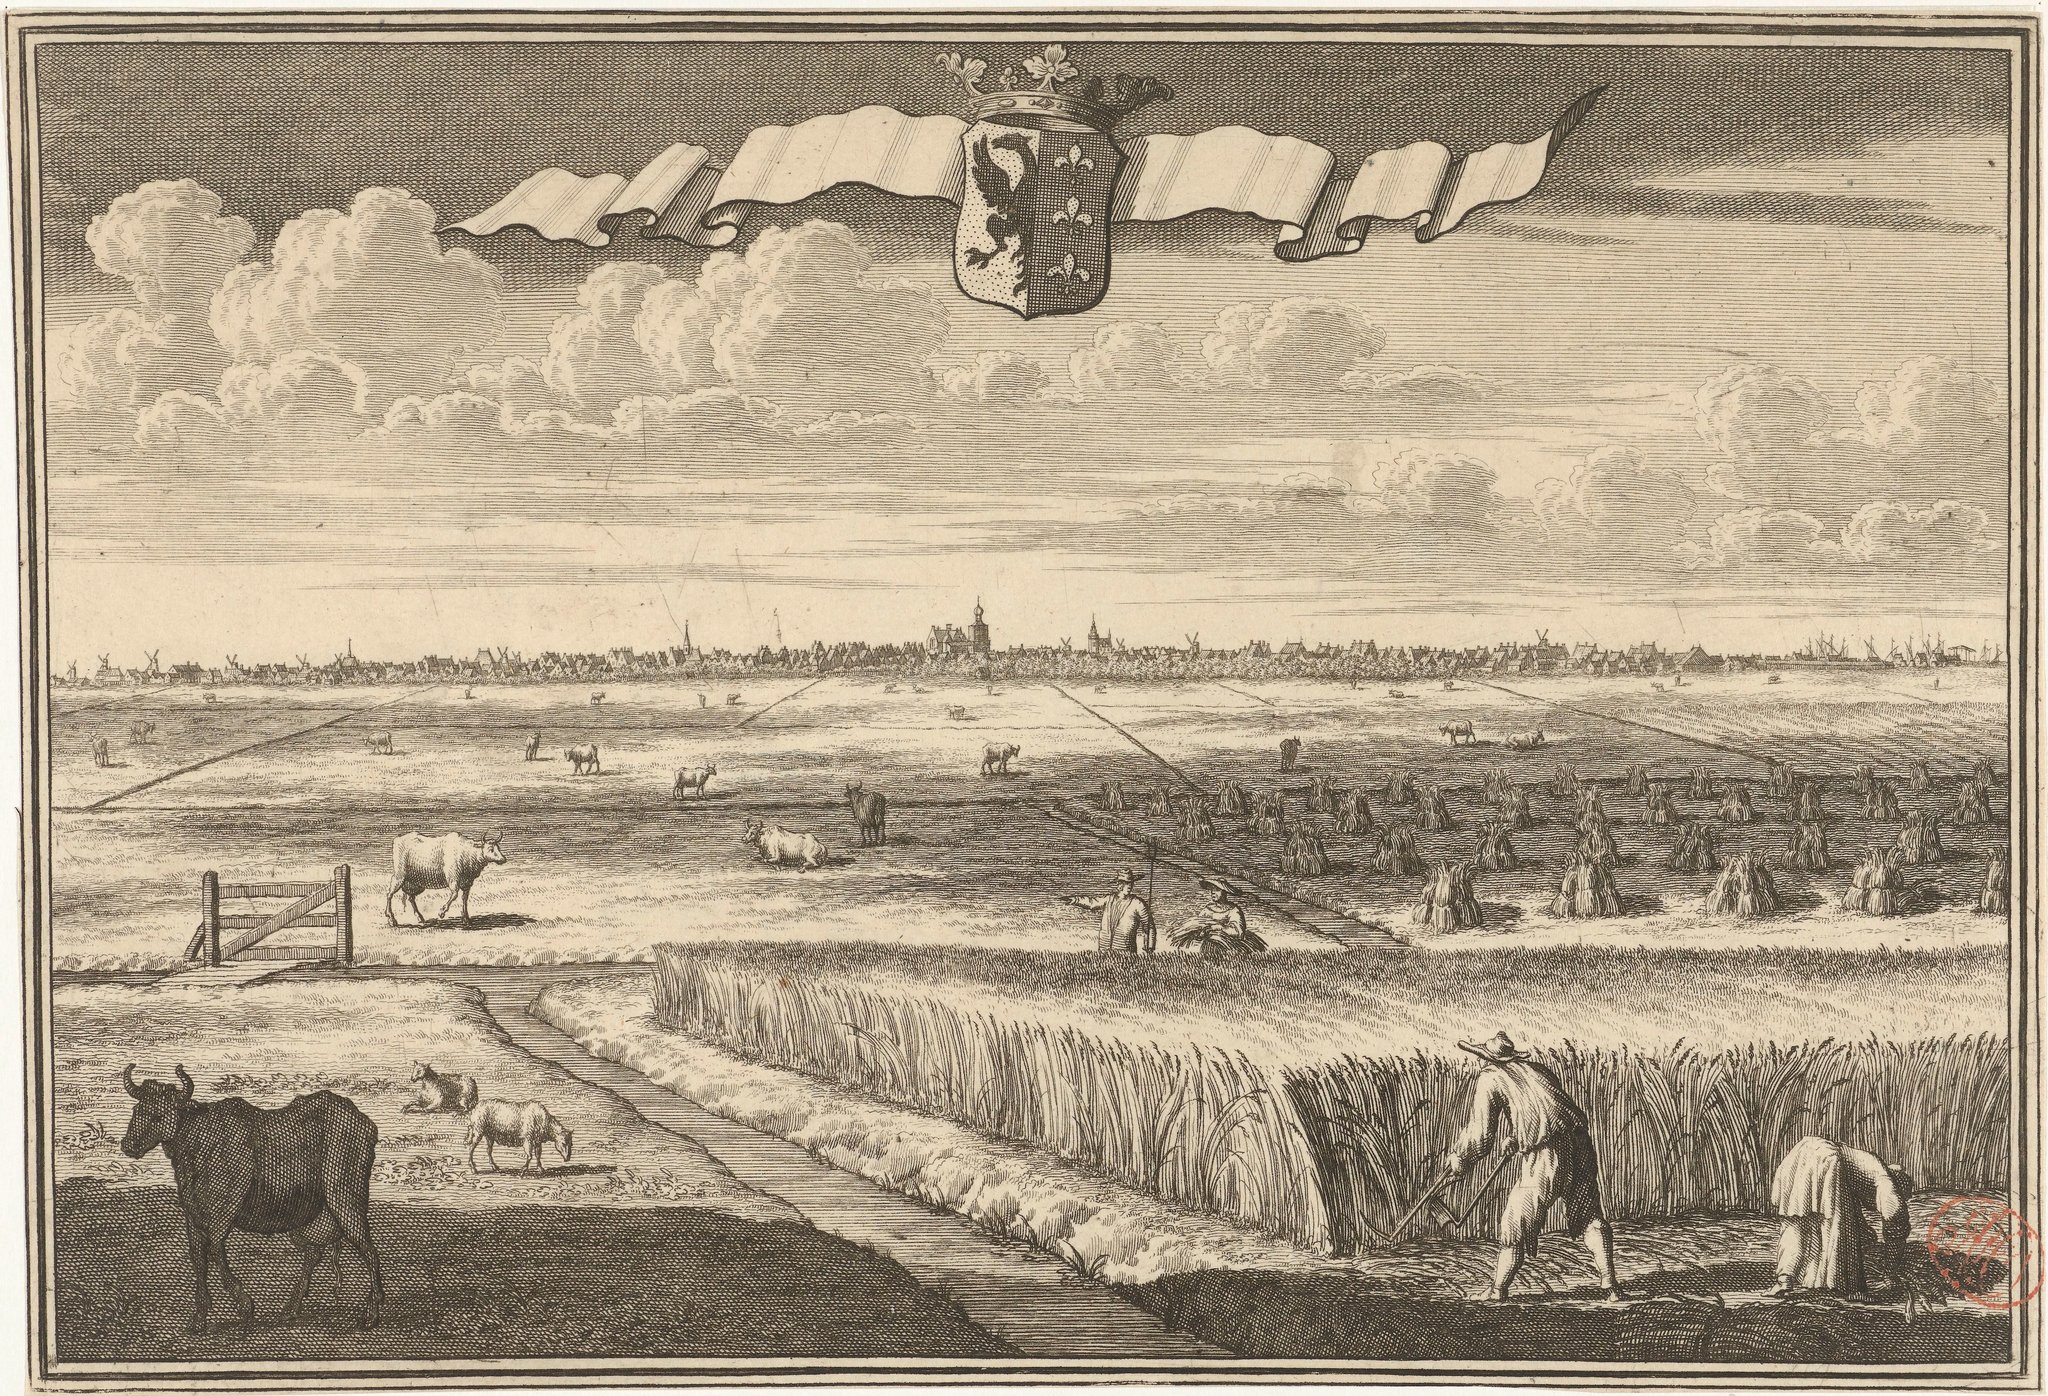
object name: print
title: Gezicht op Workum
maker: jacob folkema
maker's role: draughtsman, print maker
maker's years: 1692-1767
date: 1702-1767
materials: paper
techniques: etching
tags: city-view, and landscape with man-made constructions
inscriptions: collector's mark: Lugt 195, collector's mark: Lugt 2228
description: Gezicht op de stad Workum, gezien vanaf het land waar vee graast en boeren werken. Boven de stad prijkt een nog te bewerken banderol en het wapen van de stad.